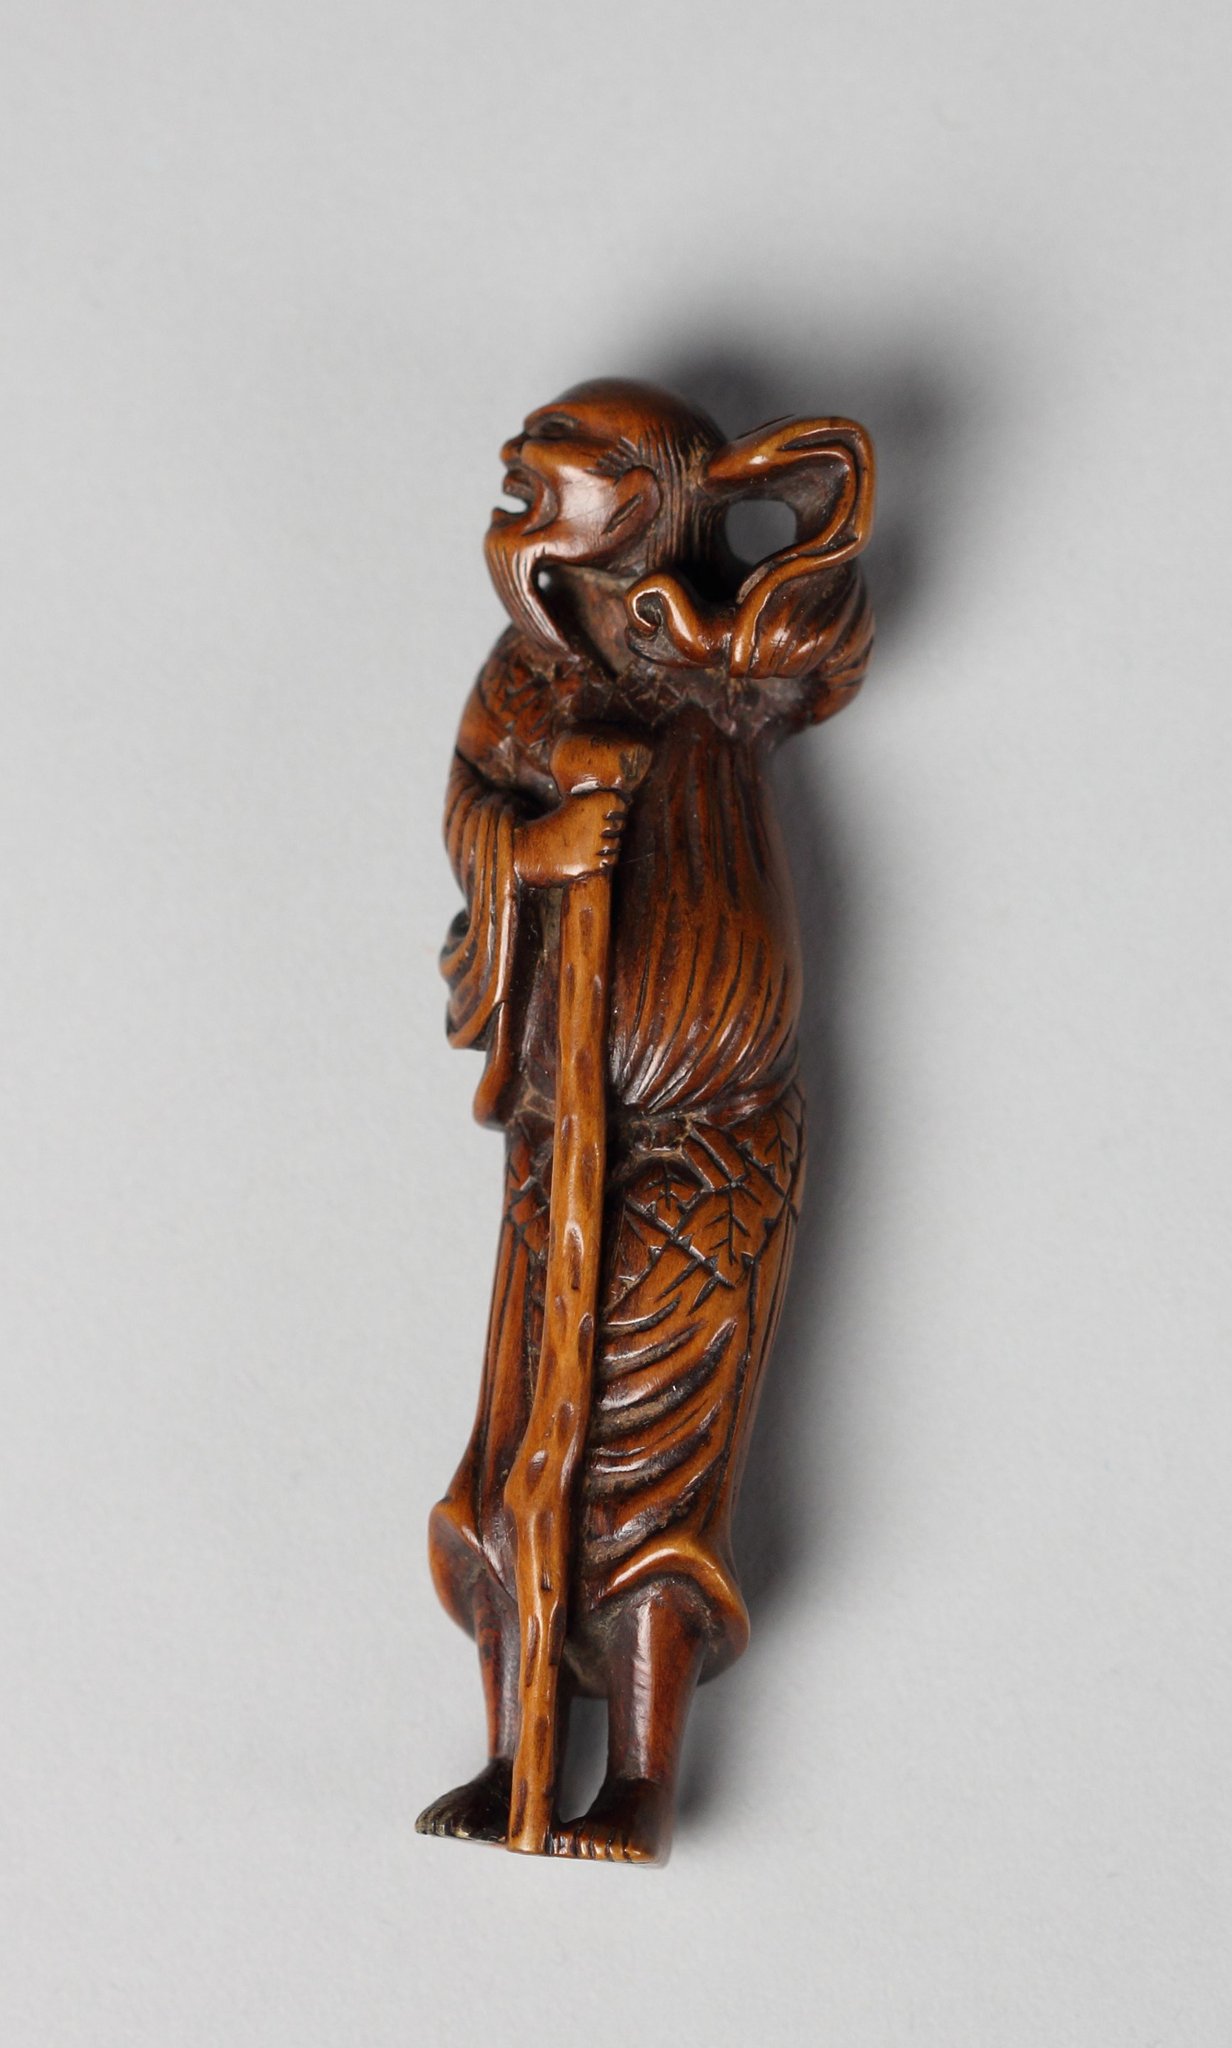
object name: netsuke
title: Netsuke of an Arhat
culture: japanese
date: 1801-1900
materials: wood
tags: men